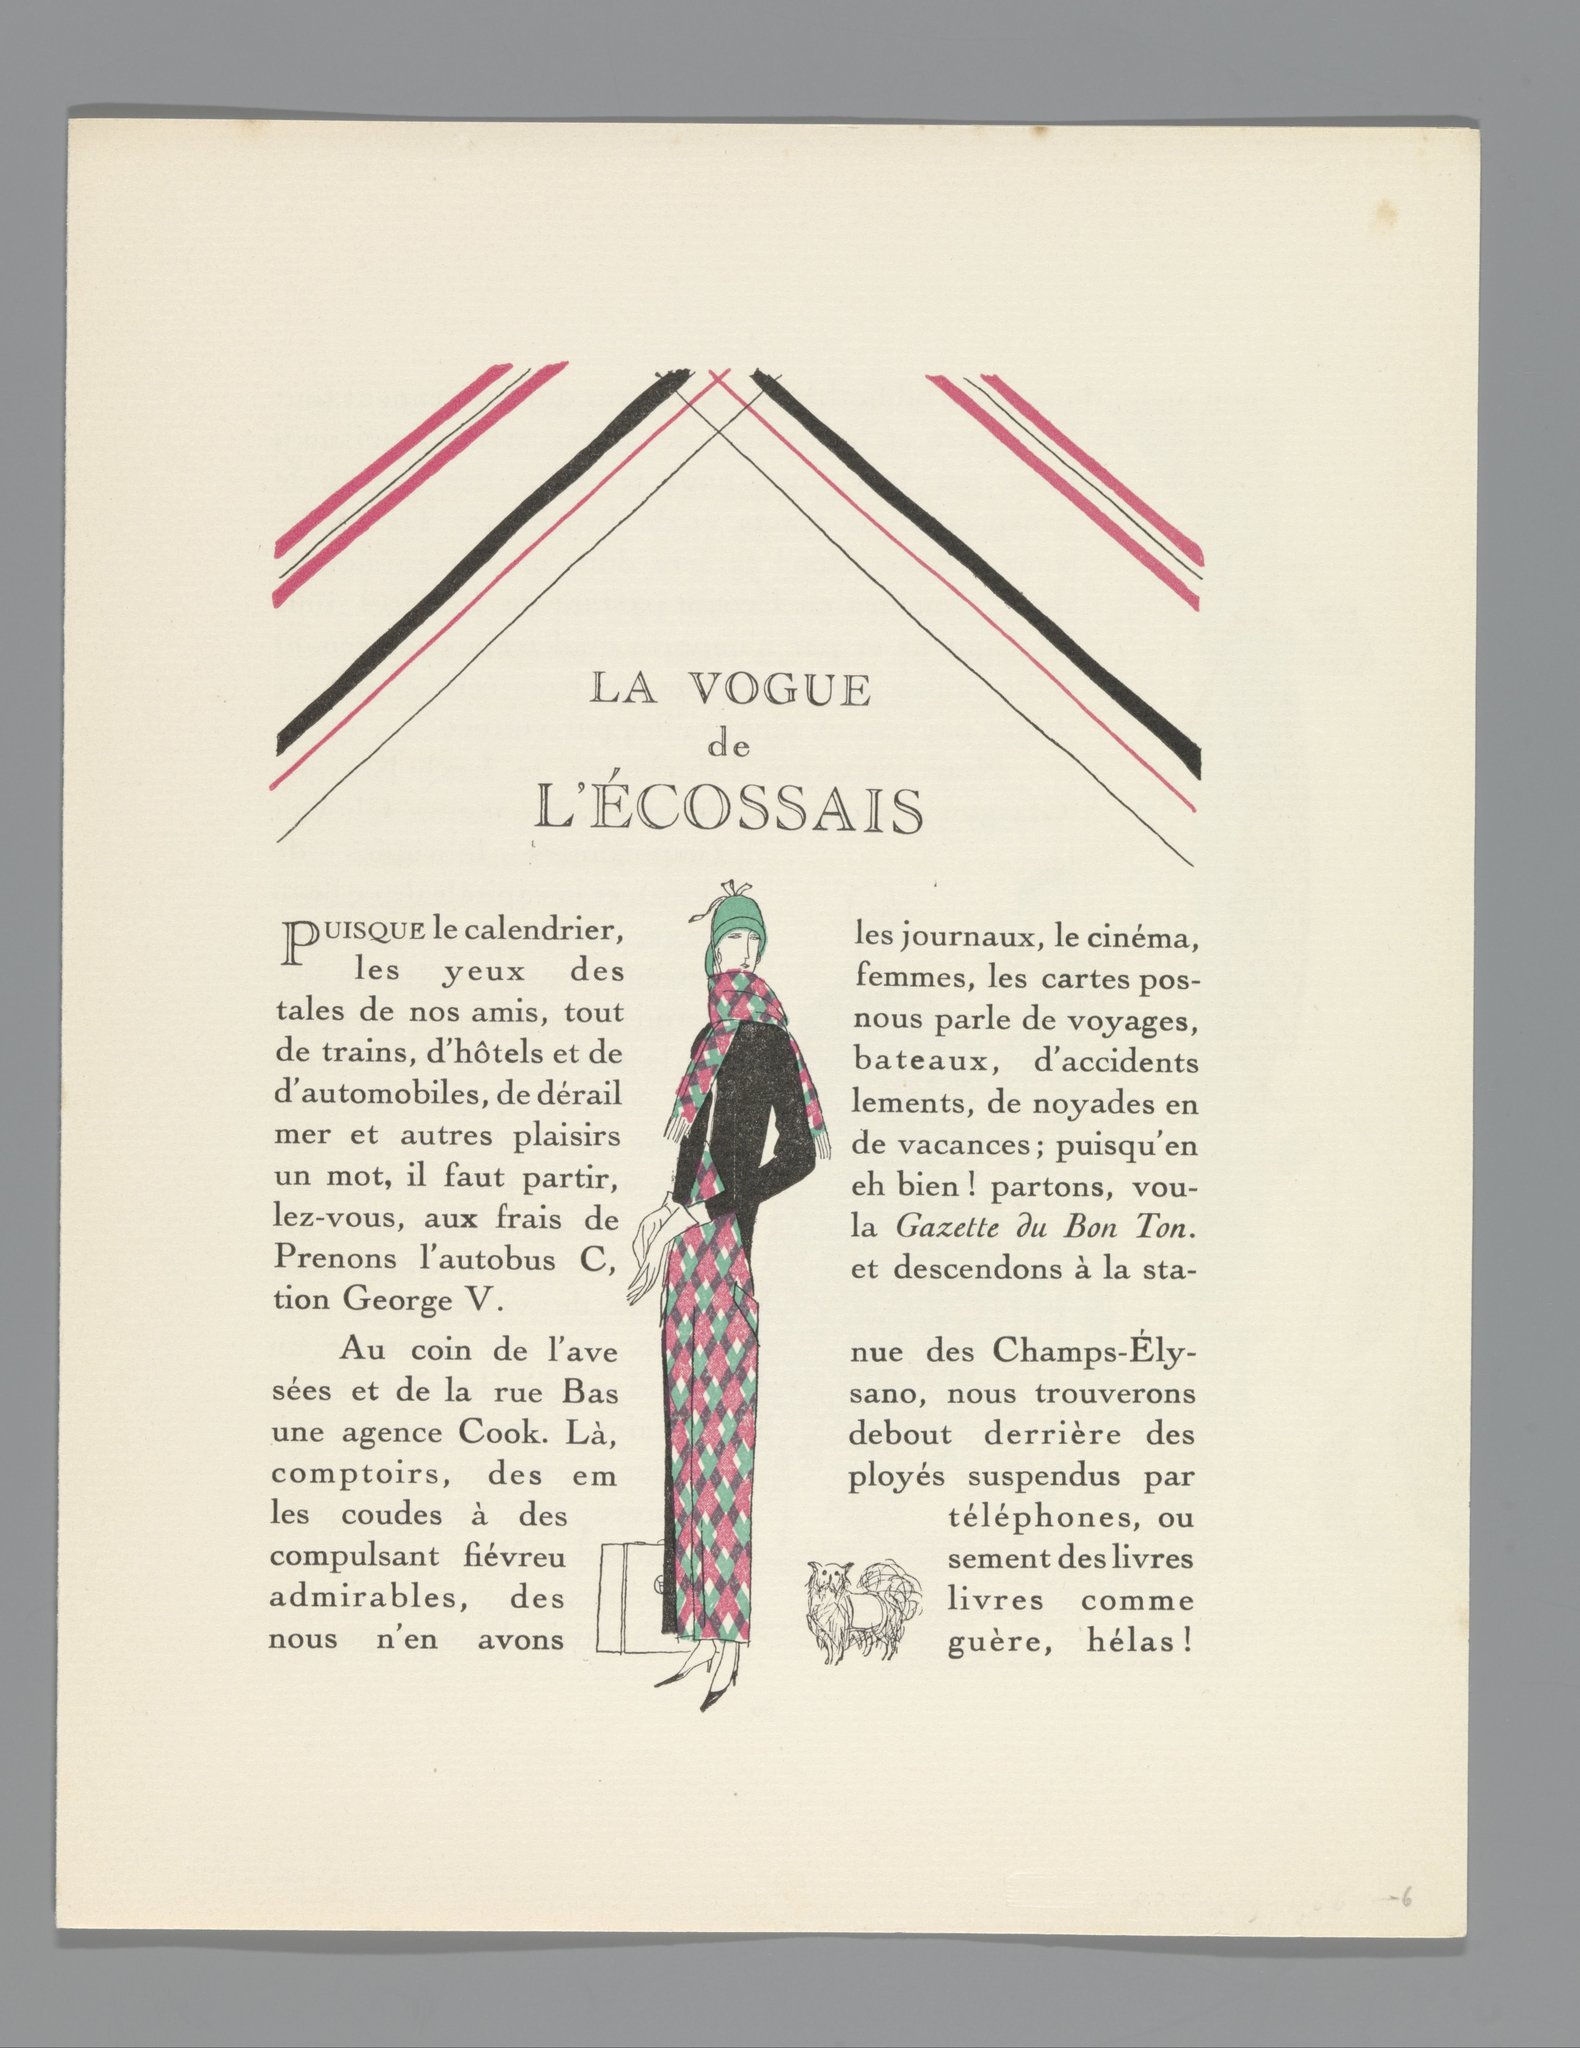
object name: magazine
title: Gazette du Bon Ton, No. 2 - 1923, 6e Année, p. 49: La Vogue de l'Écossais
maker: lucien vogel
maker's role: publisher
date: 1923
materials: paper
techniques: letterpress printing, photochemical processes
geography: paris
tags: gloves, mittens (long gloves) (+ women's clothes), neck-gear ~ clothing (shawl) (+ women's clothes), fashion plates, head-gear: hat (+ women's clothes), skirt (+ women's clothes), trunk, suit-case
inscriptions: date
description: Titel 'La Vogue de l'Écossais' (de Schotse mode) Tekst en als illustratie een jong vrouw in lange rok in schotse ruit; dito sjaal. Naast haar een koffer en een kleine hond.